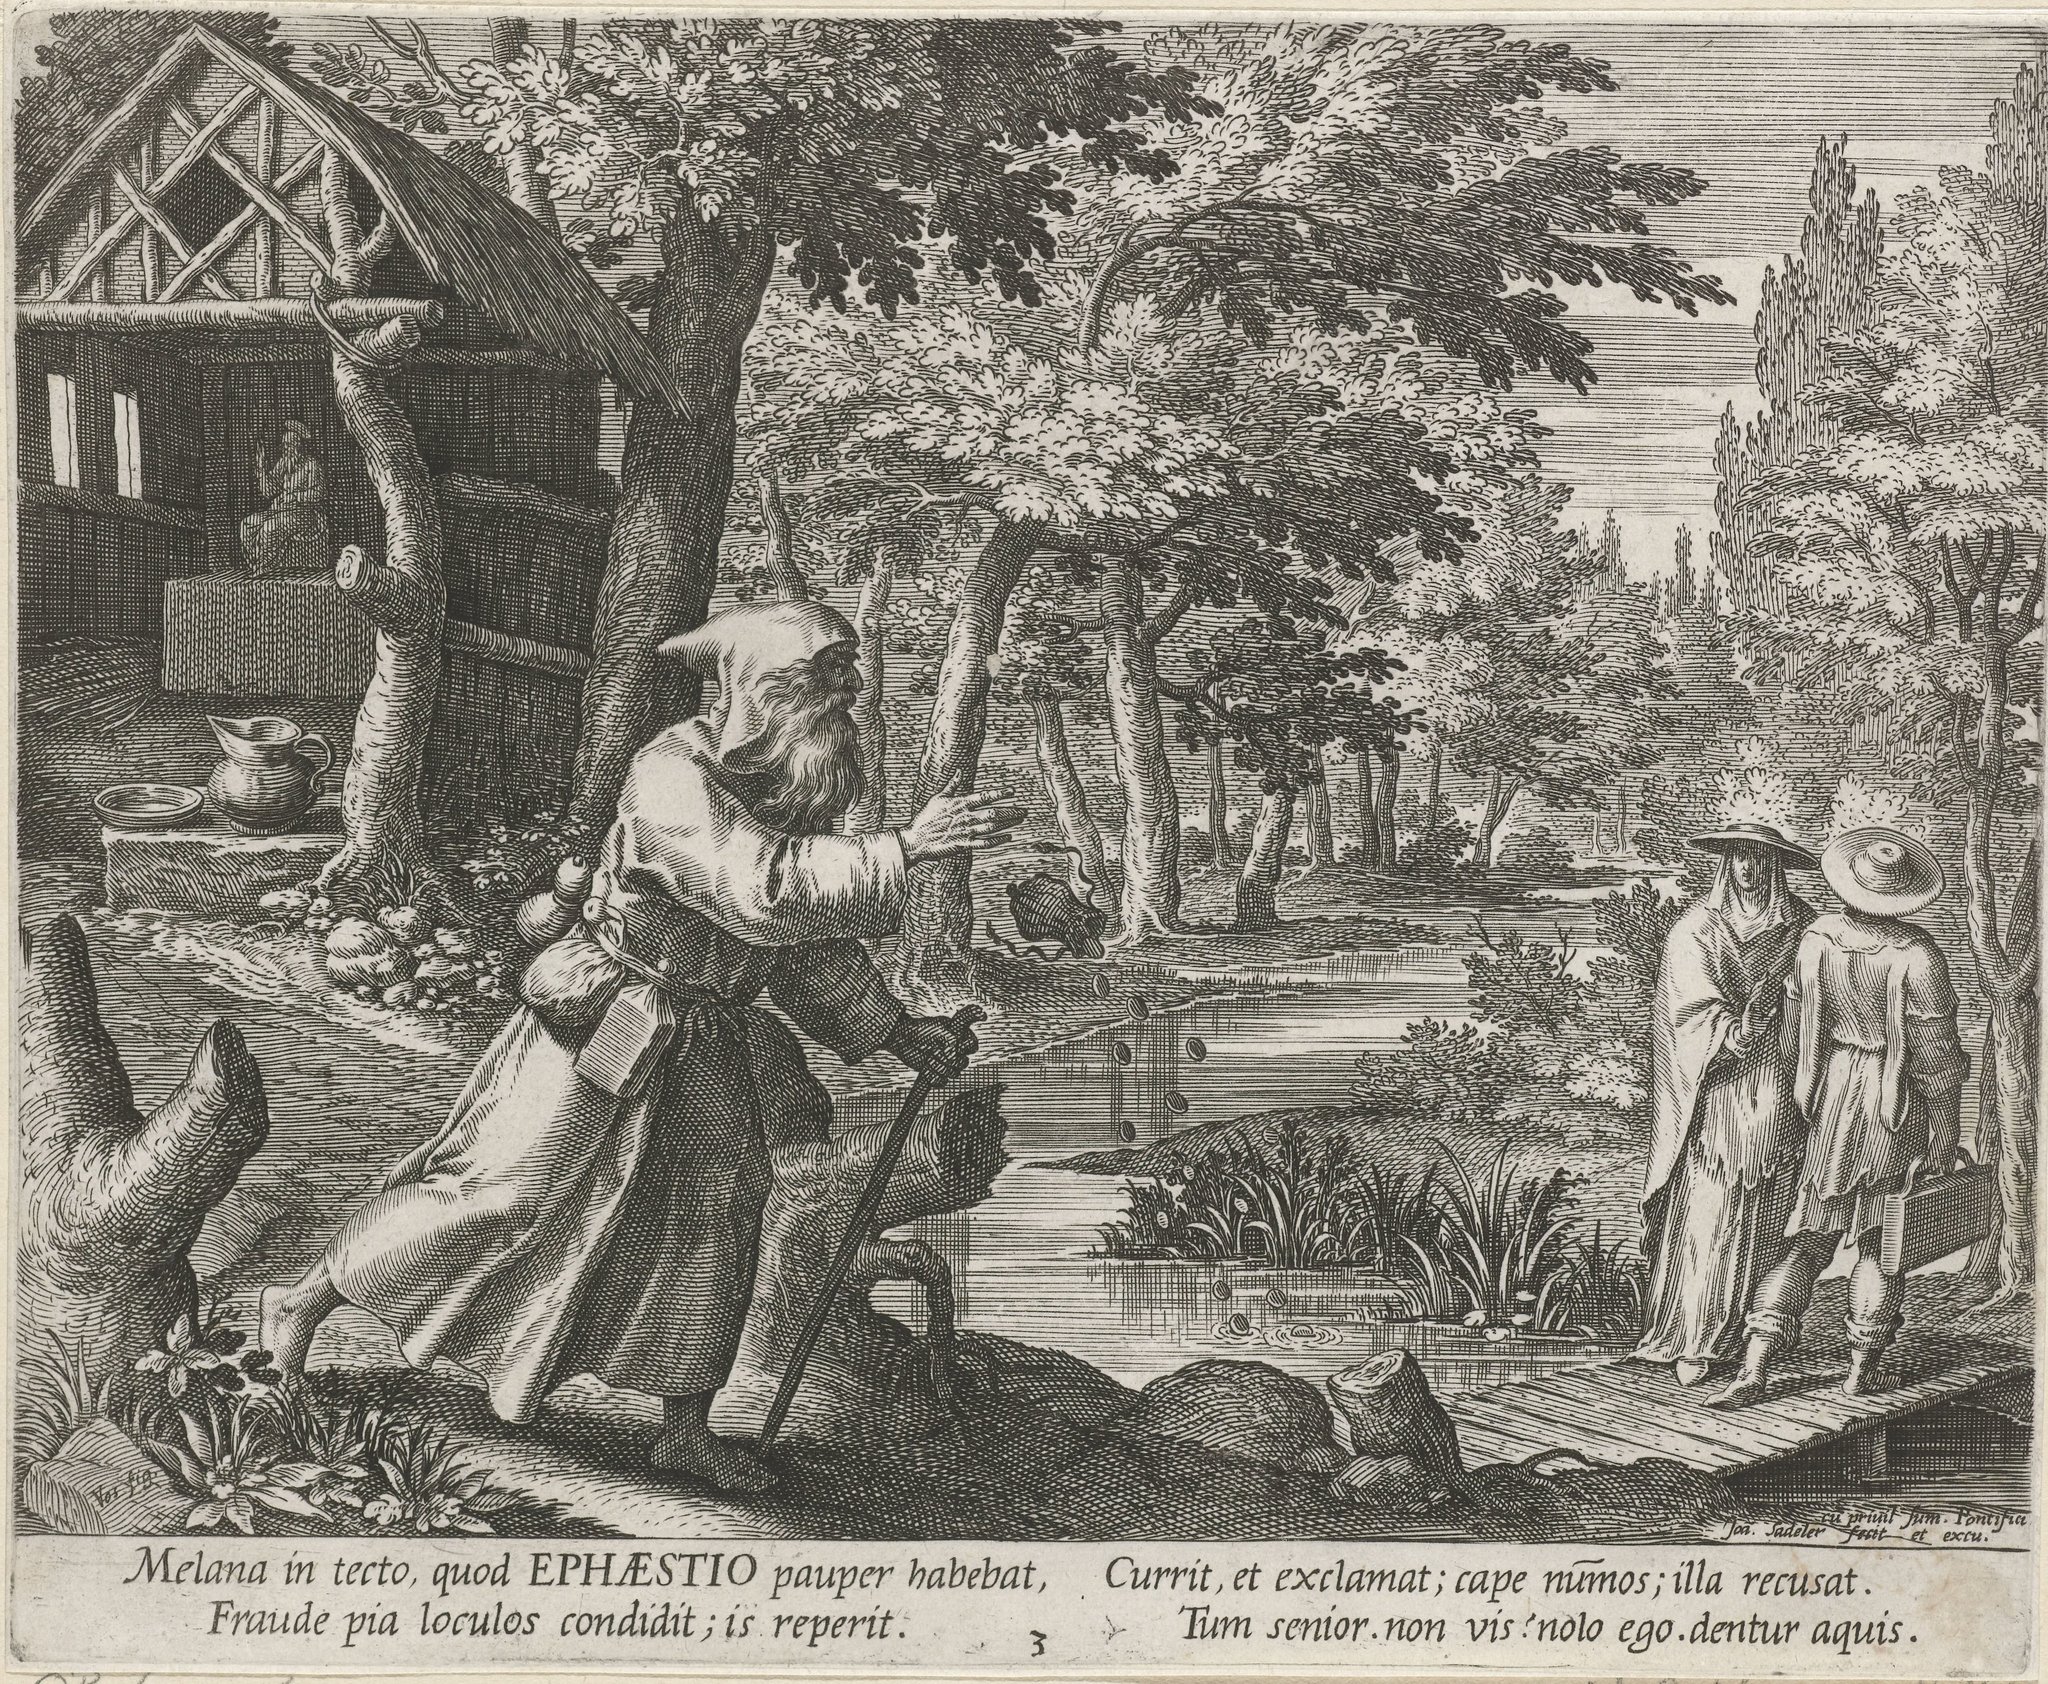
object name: print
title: Kluizenaars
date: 1600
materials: paper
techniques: engraving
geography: venice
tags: forest, wood, anchorite, hermit, 'en route', traveller under way, money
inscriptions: collector's mark: Lugt 240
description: Op de voorgrond de kluizenaar Ephaestius. Hij gooit een buidel met munten in het water. Achter hem zijn kluizenaarshut. Links een paar reizigers die een brug oversteken. Op de achtergrond een boslandschap.